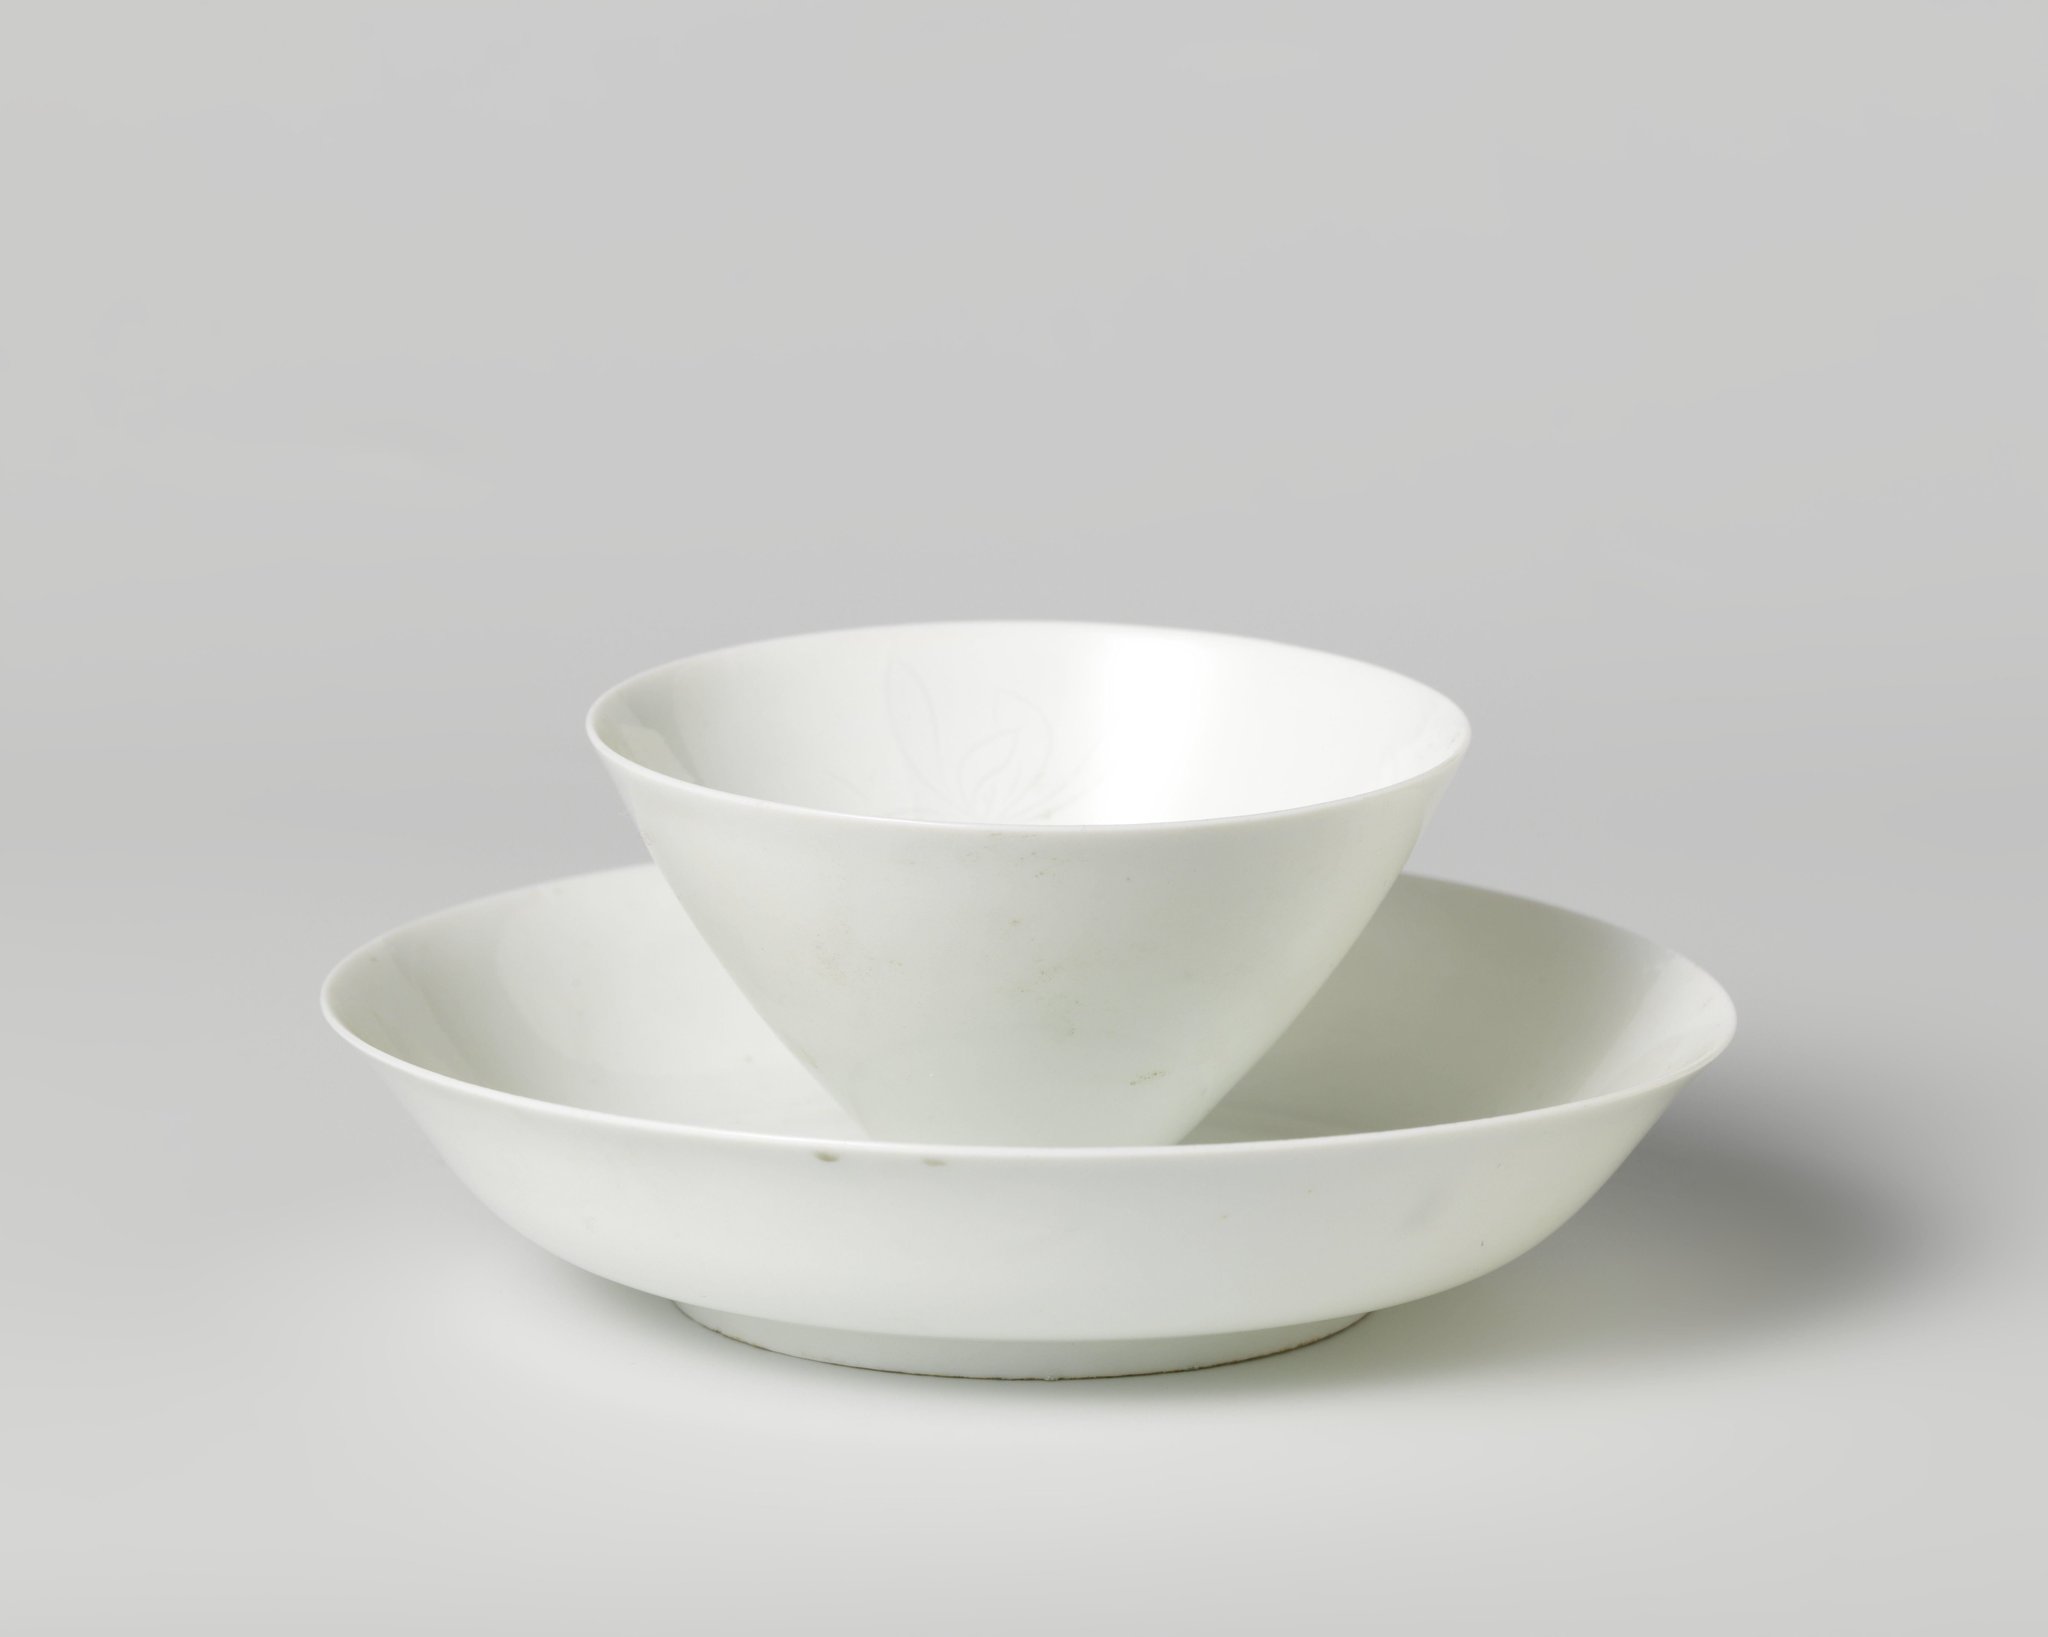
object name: kop en schotel, kop en schotel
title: Cup and saucer with incised flower heads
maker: Anonymous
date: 1800-1849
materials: glaze, porcelain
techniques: engraving, firing, turning, vitrification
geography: china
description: Kop en schotel van porselein, bedekt met een doorschijnend wit glazuur. Conisch gevormde kop met aan de binnenzijde vier ingegrifte bloemen; niet bijpassende, ongedecoreerde schotel. Blanc de Chine.